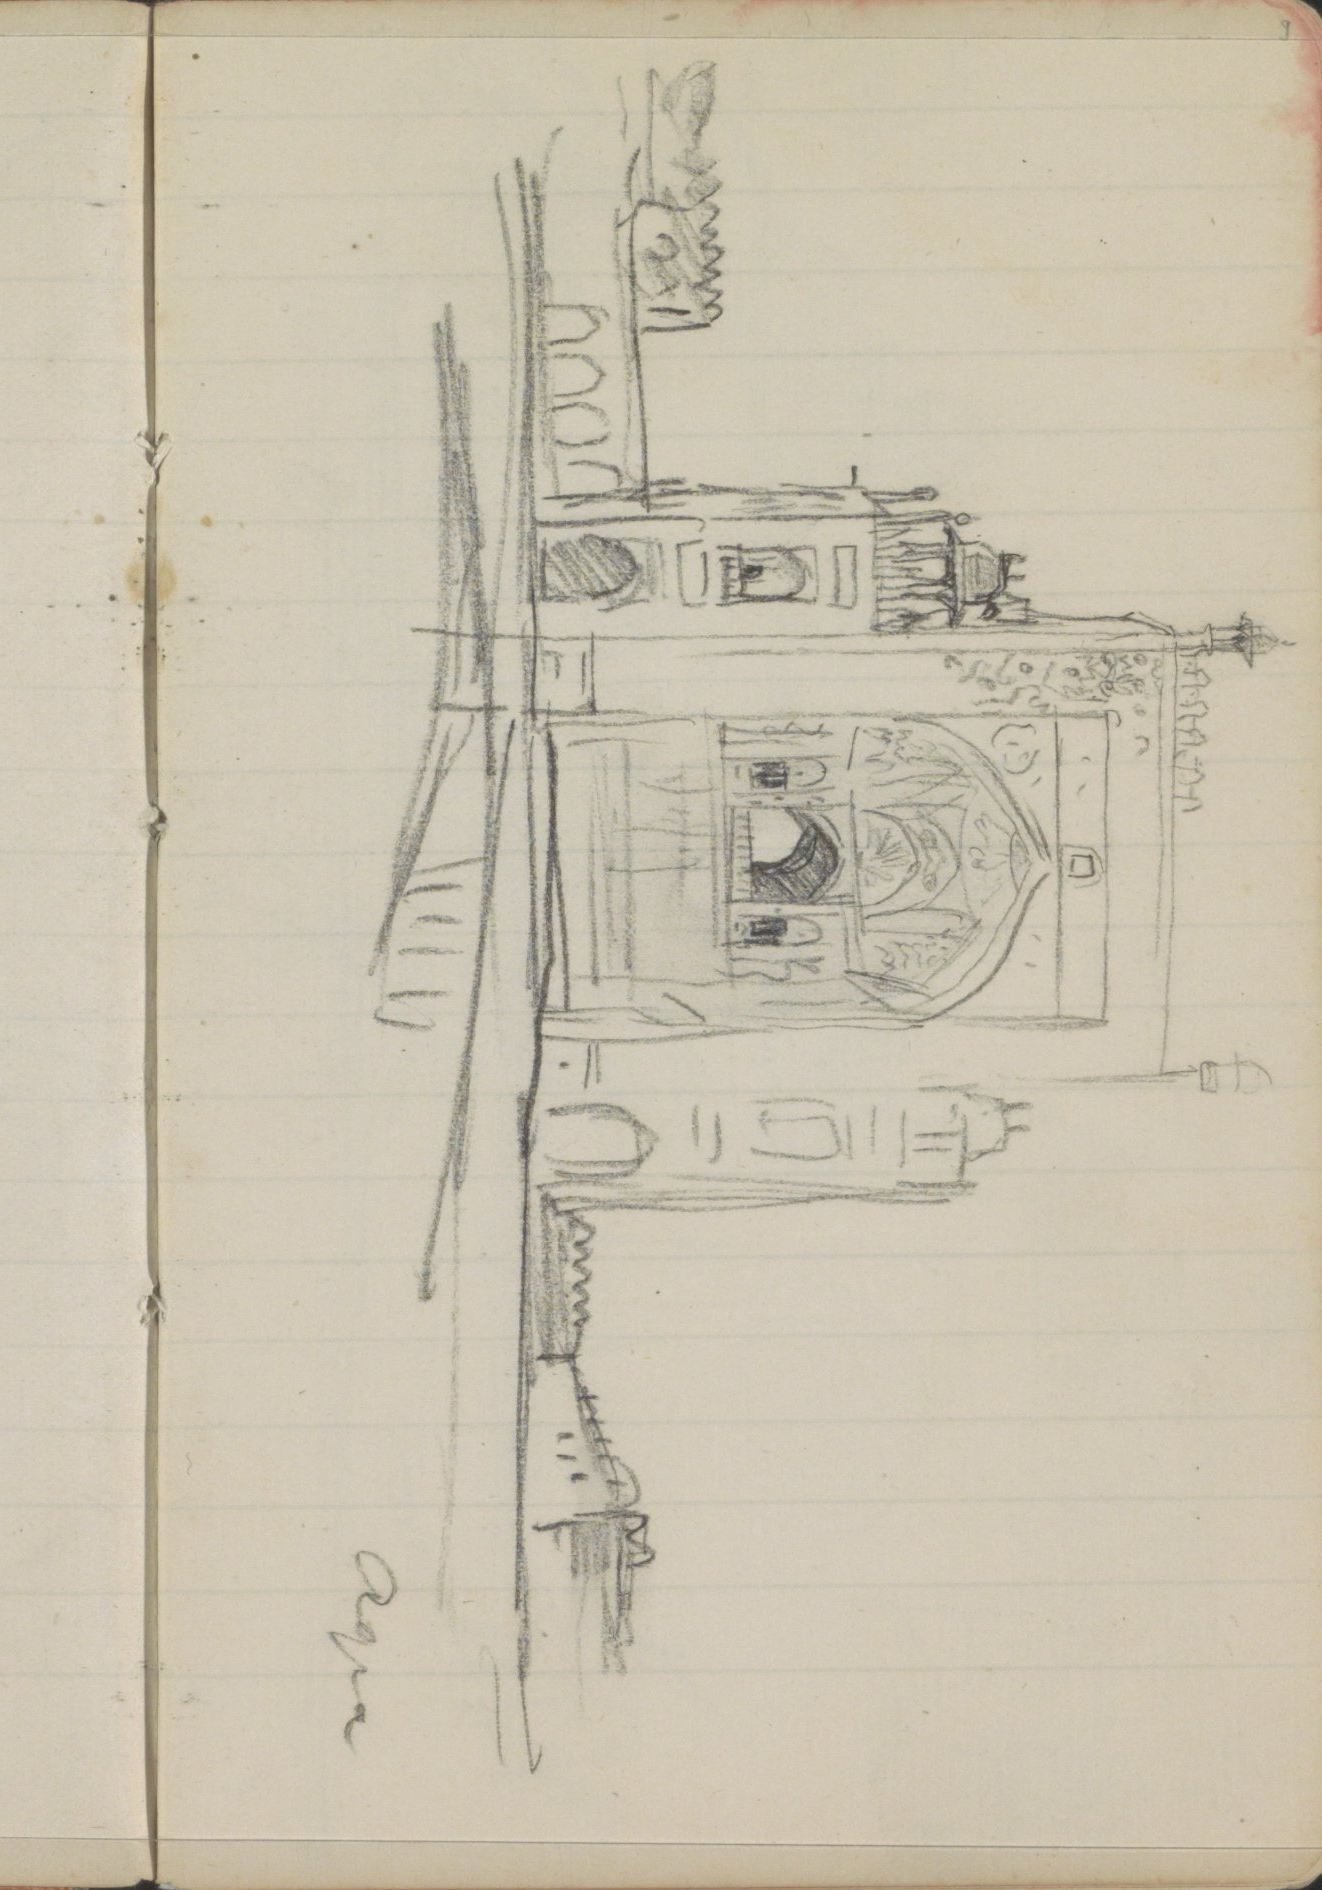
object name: sketchbook leaf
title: Poort in Agra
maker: marius bauer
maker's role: draughtsman, print maker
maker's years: 1867-1932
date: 1897-1898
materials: chalk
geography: agra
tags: arch, archivolt ~ architecture, architecture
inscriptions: annotation: ‘Agra’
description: Mogelijk een toegangsweg tot het fort van Agra. Pagina 9 uit een schetsboek met 36 bladen.